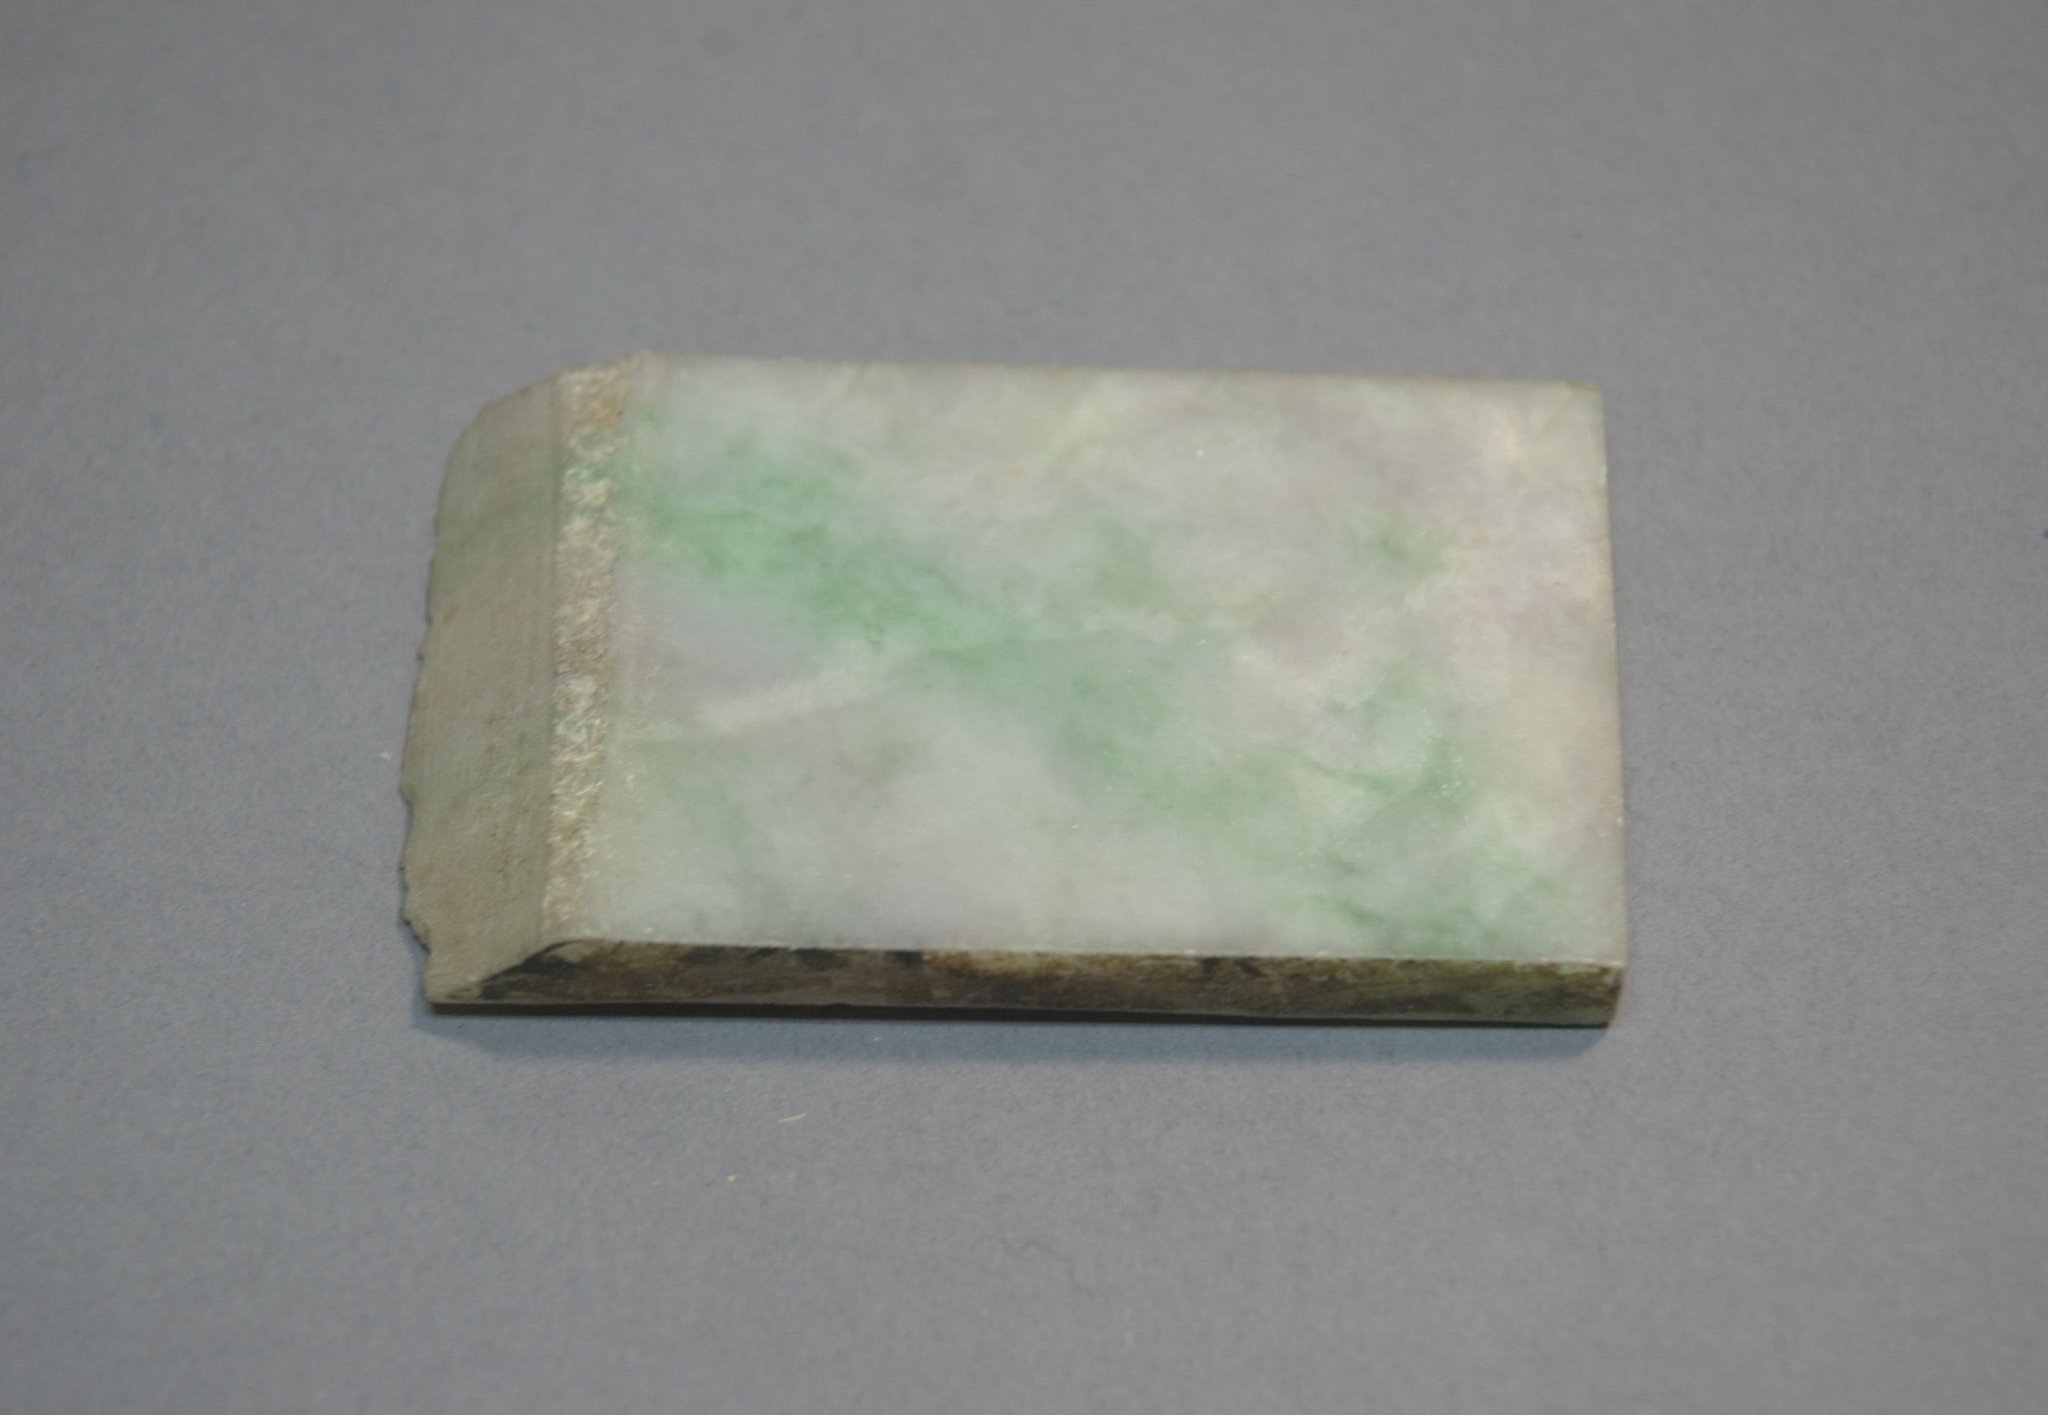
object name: jade carving material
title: Plastic Box with Piece of Burma Jadeite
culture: chinese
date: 1901-2000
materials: jade